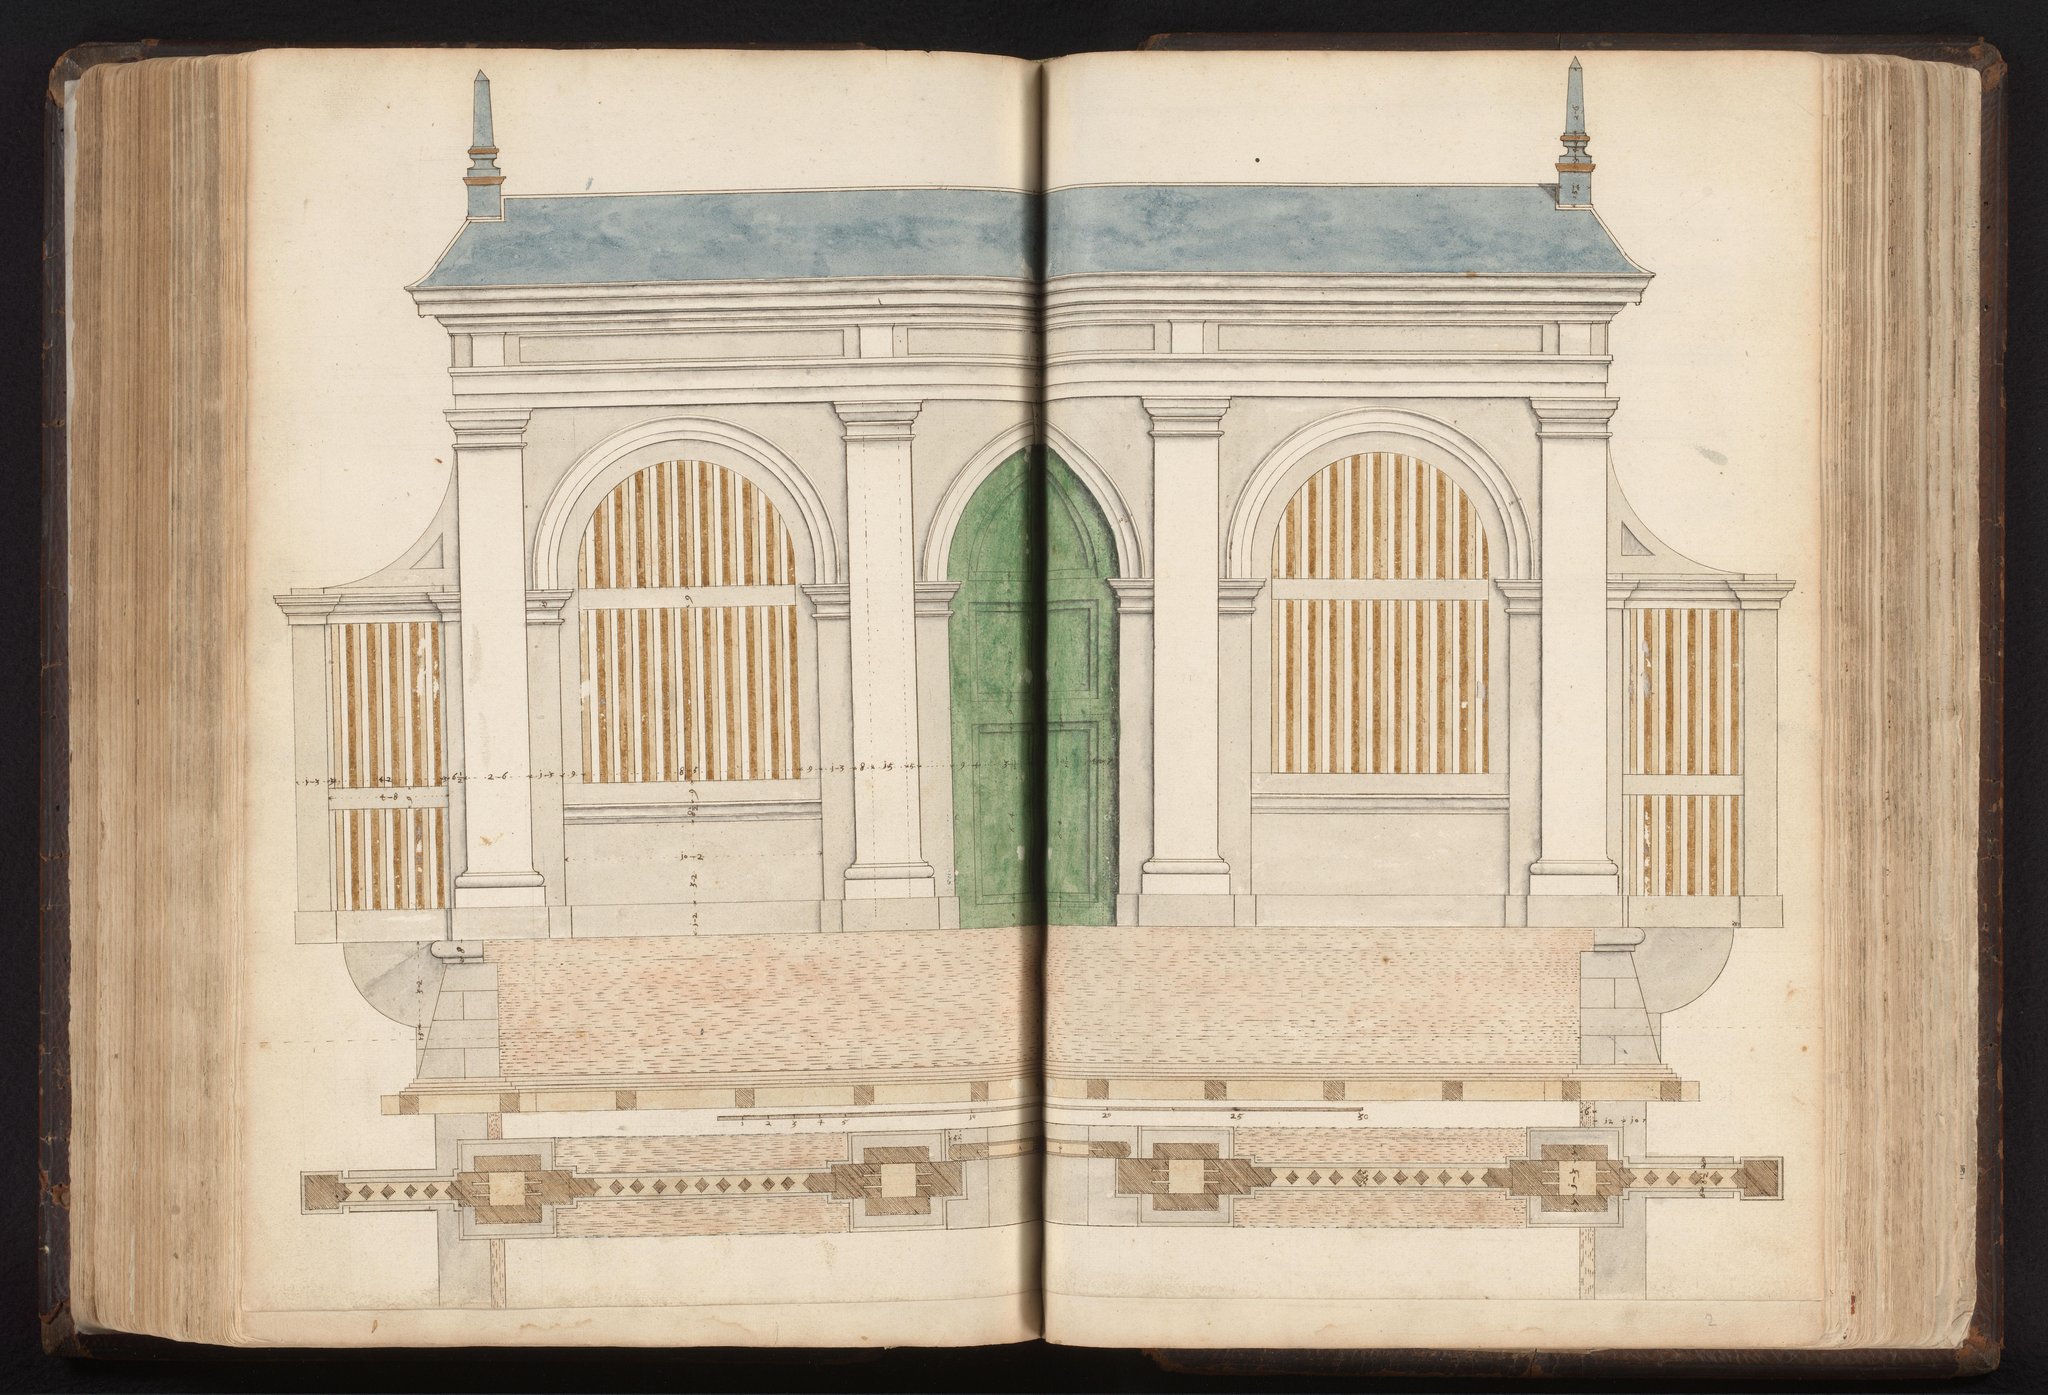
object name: drawing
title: Hamei naast de Blokhuizen in de Amstel, met fundering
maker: Anonymous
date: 1650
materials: ink, paper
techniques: brush, pen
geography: amsterdam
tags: building activities, architecture, section ~ architectural design or model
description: Met afmetingen en een doorsnede van de fundering. Tekening maakt deel uit van een album.